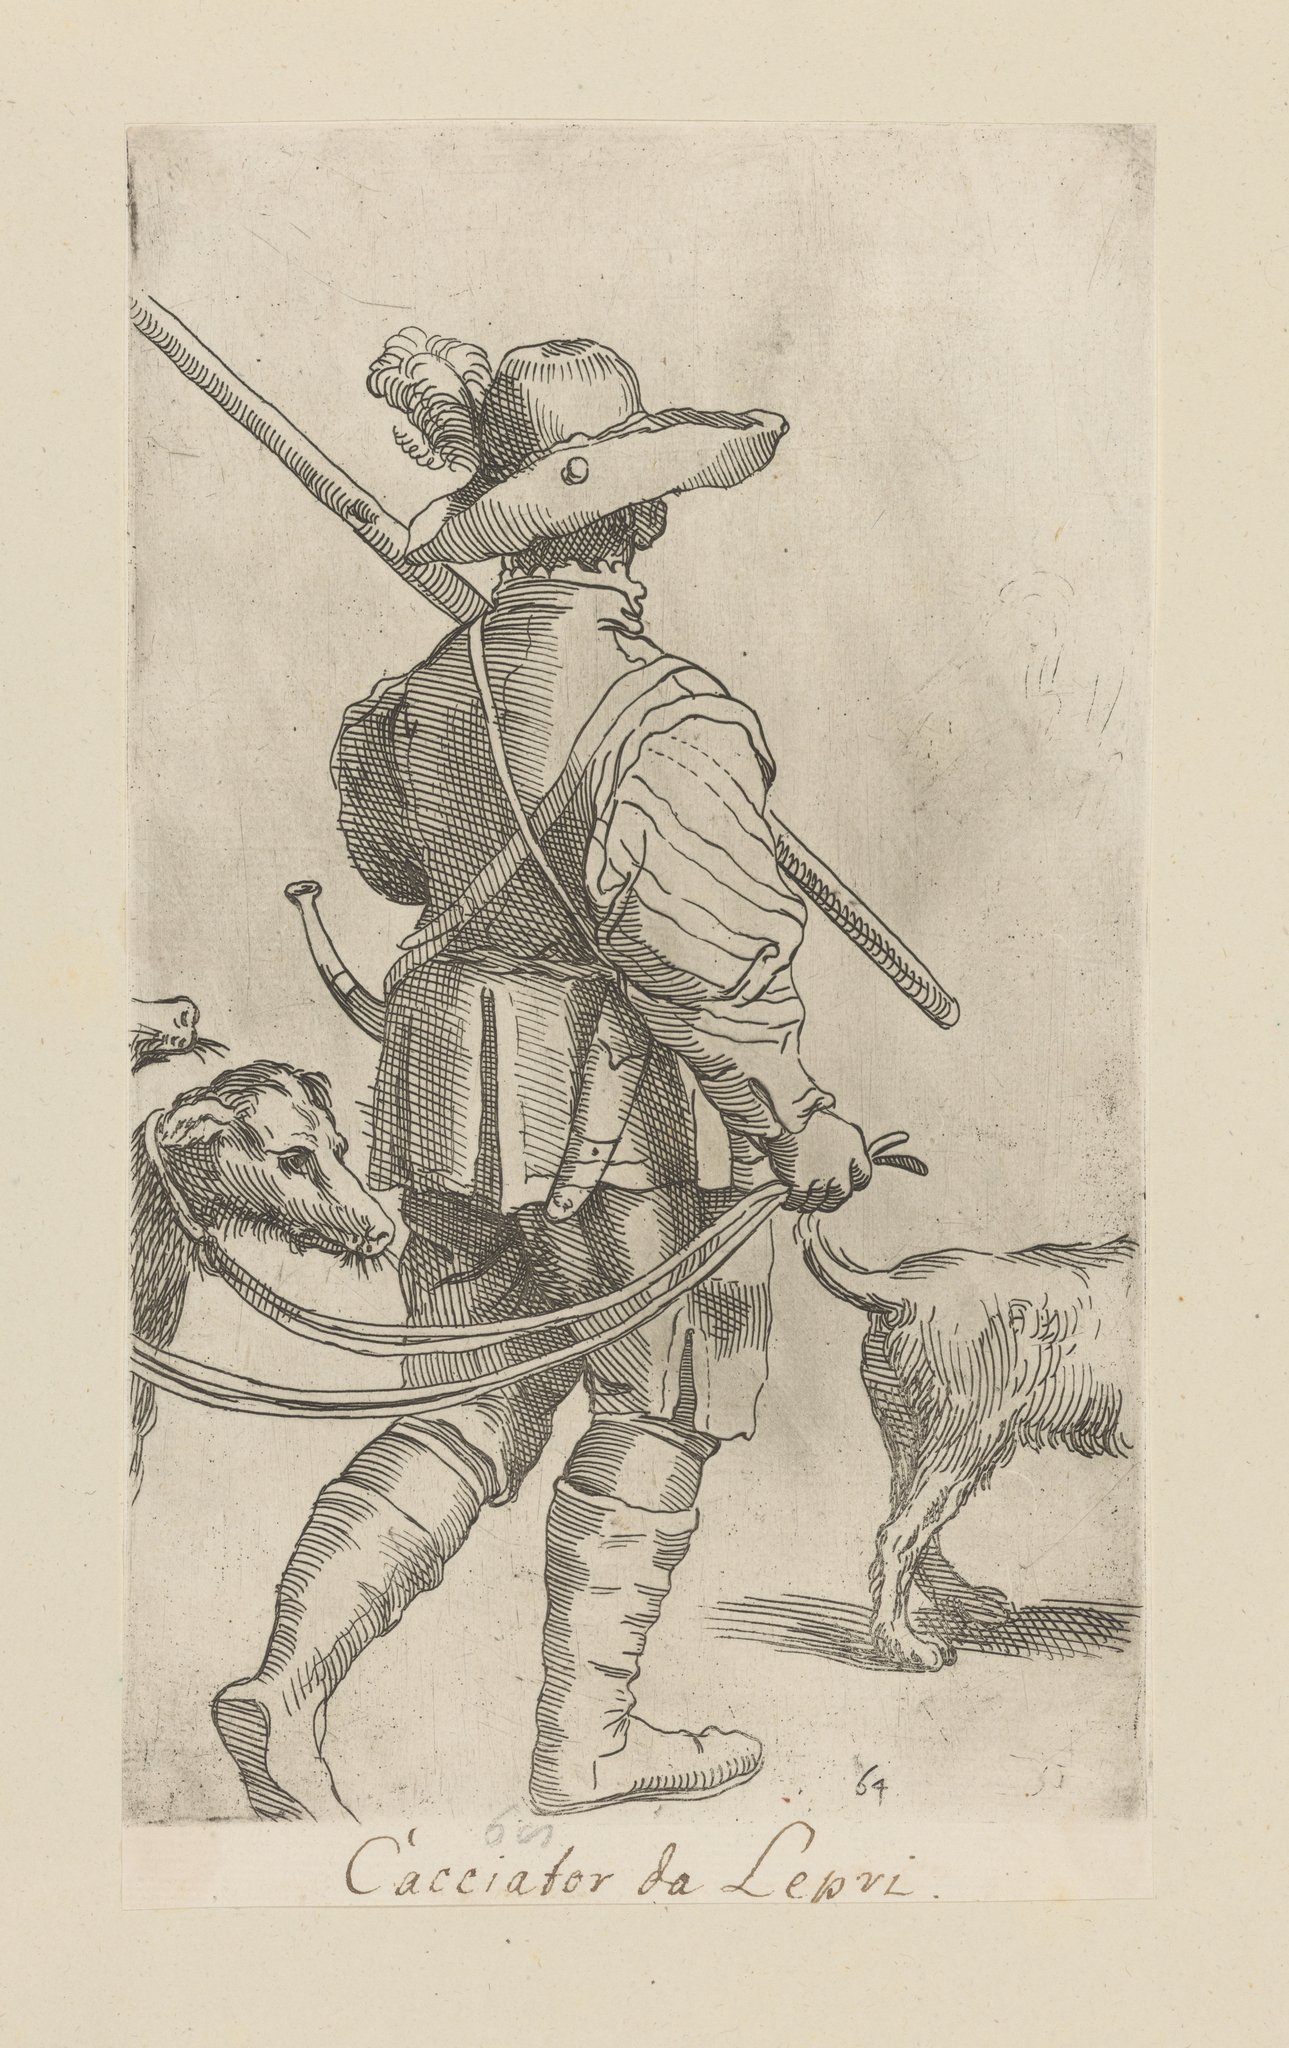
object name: print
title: Plate 64: Rabbit hunter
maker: simon guillain ii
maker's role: artist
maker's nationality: french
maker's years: 1618-1718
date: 1646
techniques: etching